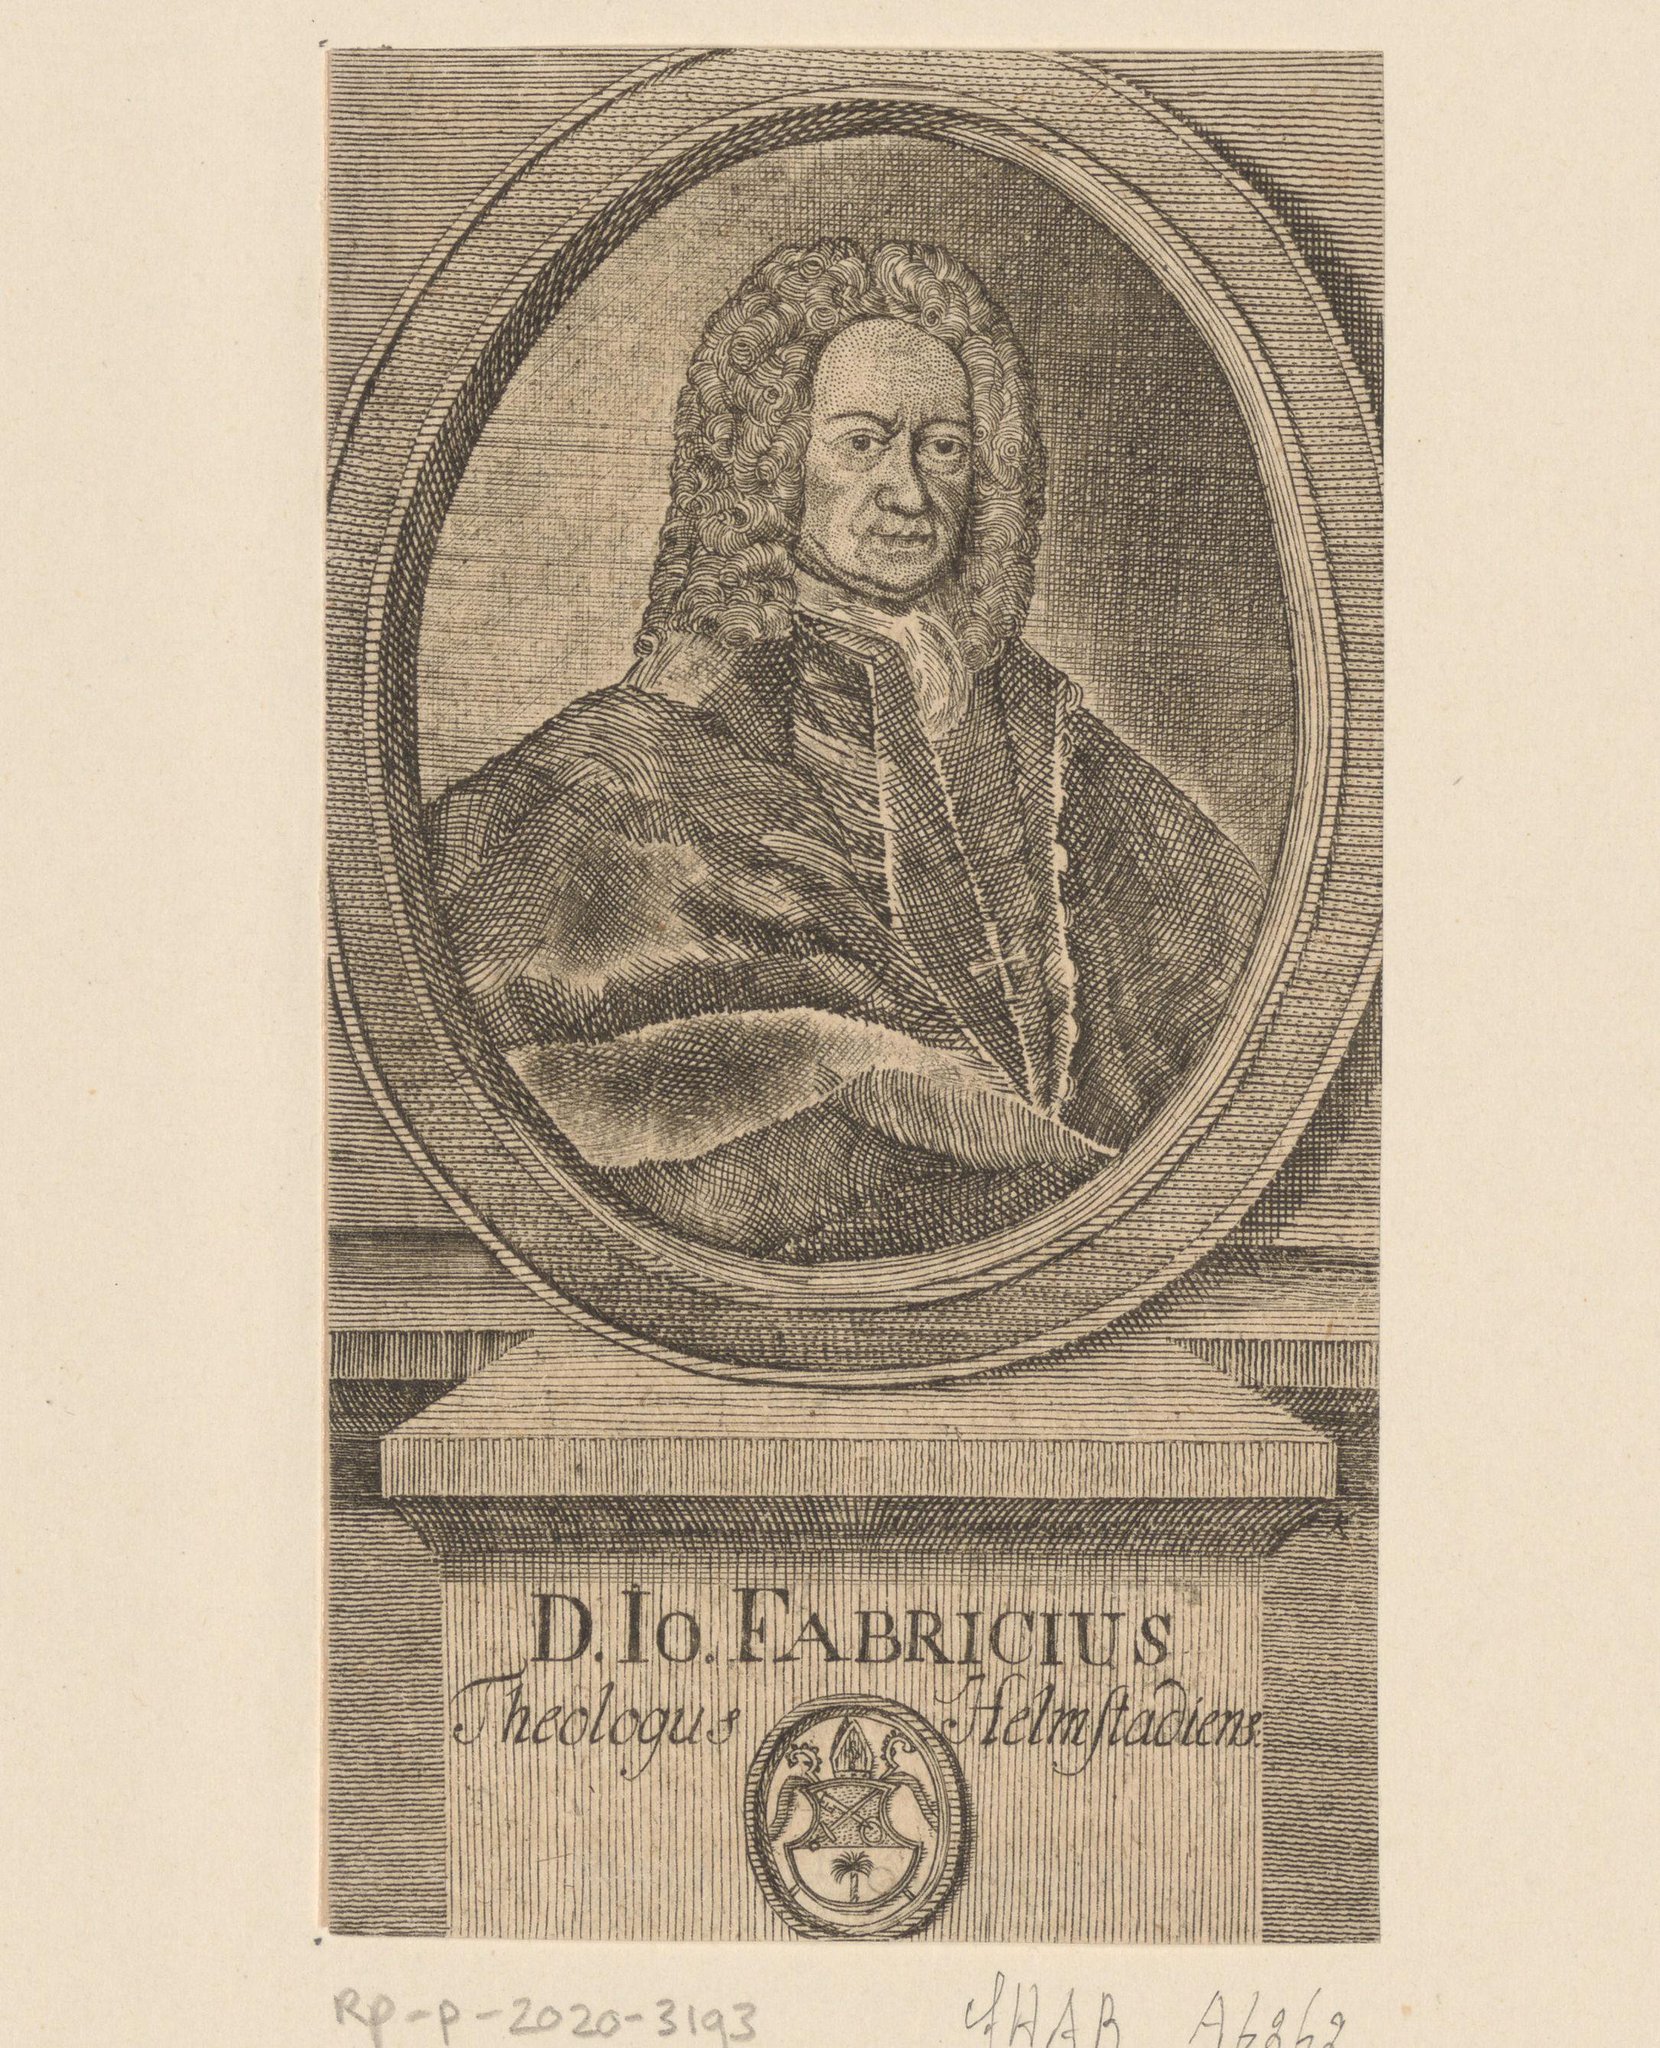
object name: print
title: Portret van Johann Fabricius IV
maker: Anonymous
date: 1741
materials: paper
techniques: engraving, etching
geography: germany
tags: theologian, historical persons, armorial bearing, heraldry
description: Prent waarschijnlijk uit: Fortgesetzte Sammlung von Alten und Neuen Theologischen Sachen (...). Fünffter Beytrag Auf das Jahr 1741. Leipzig: Carl Ludwig Jacobi, 1741.